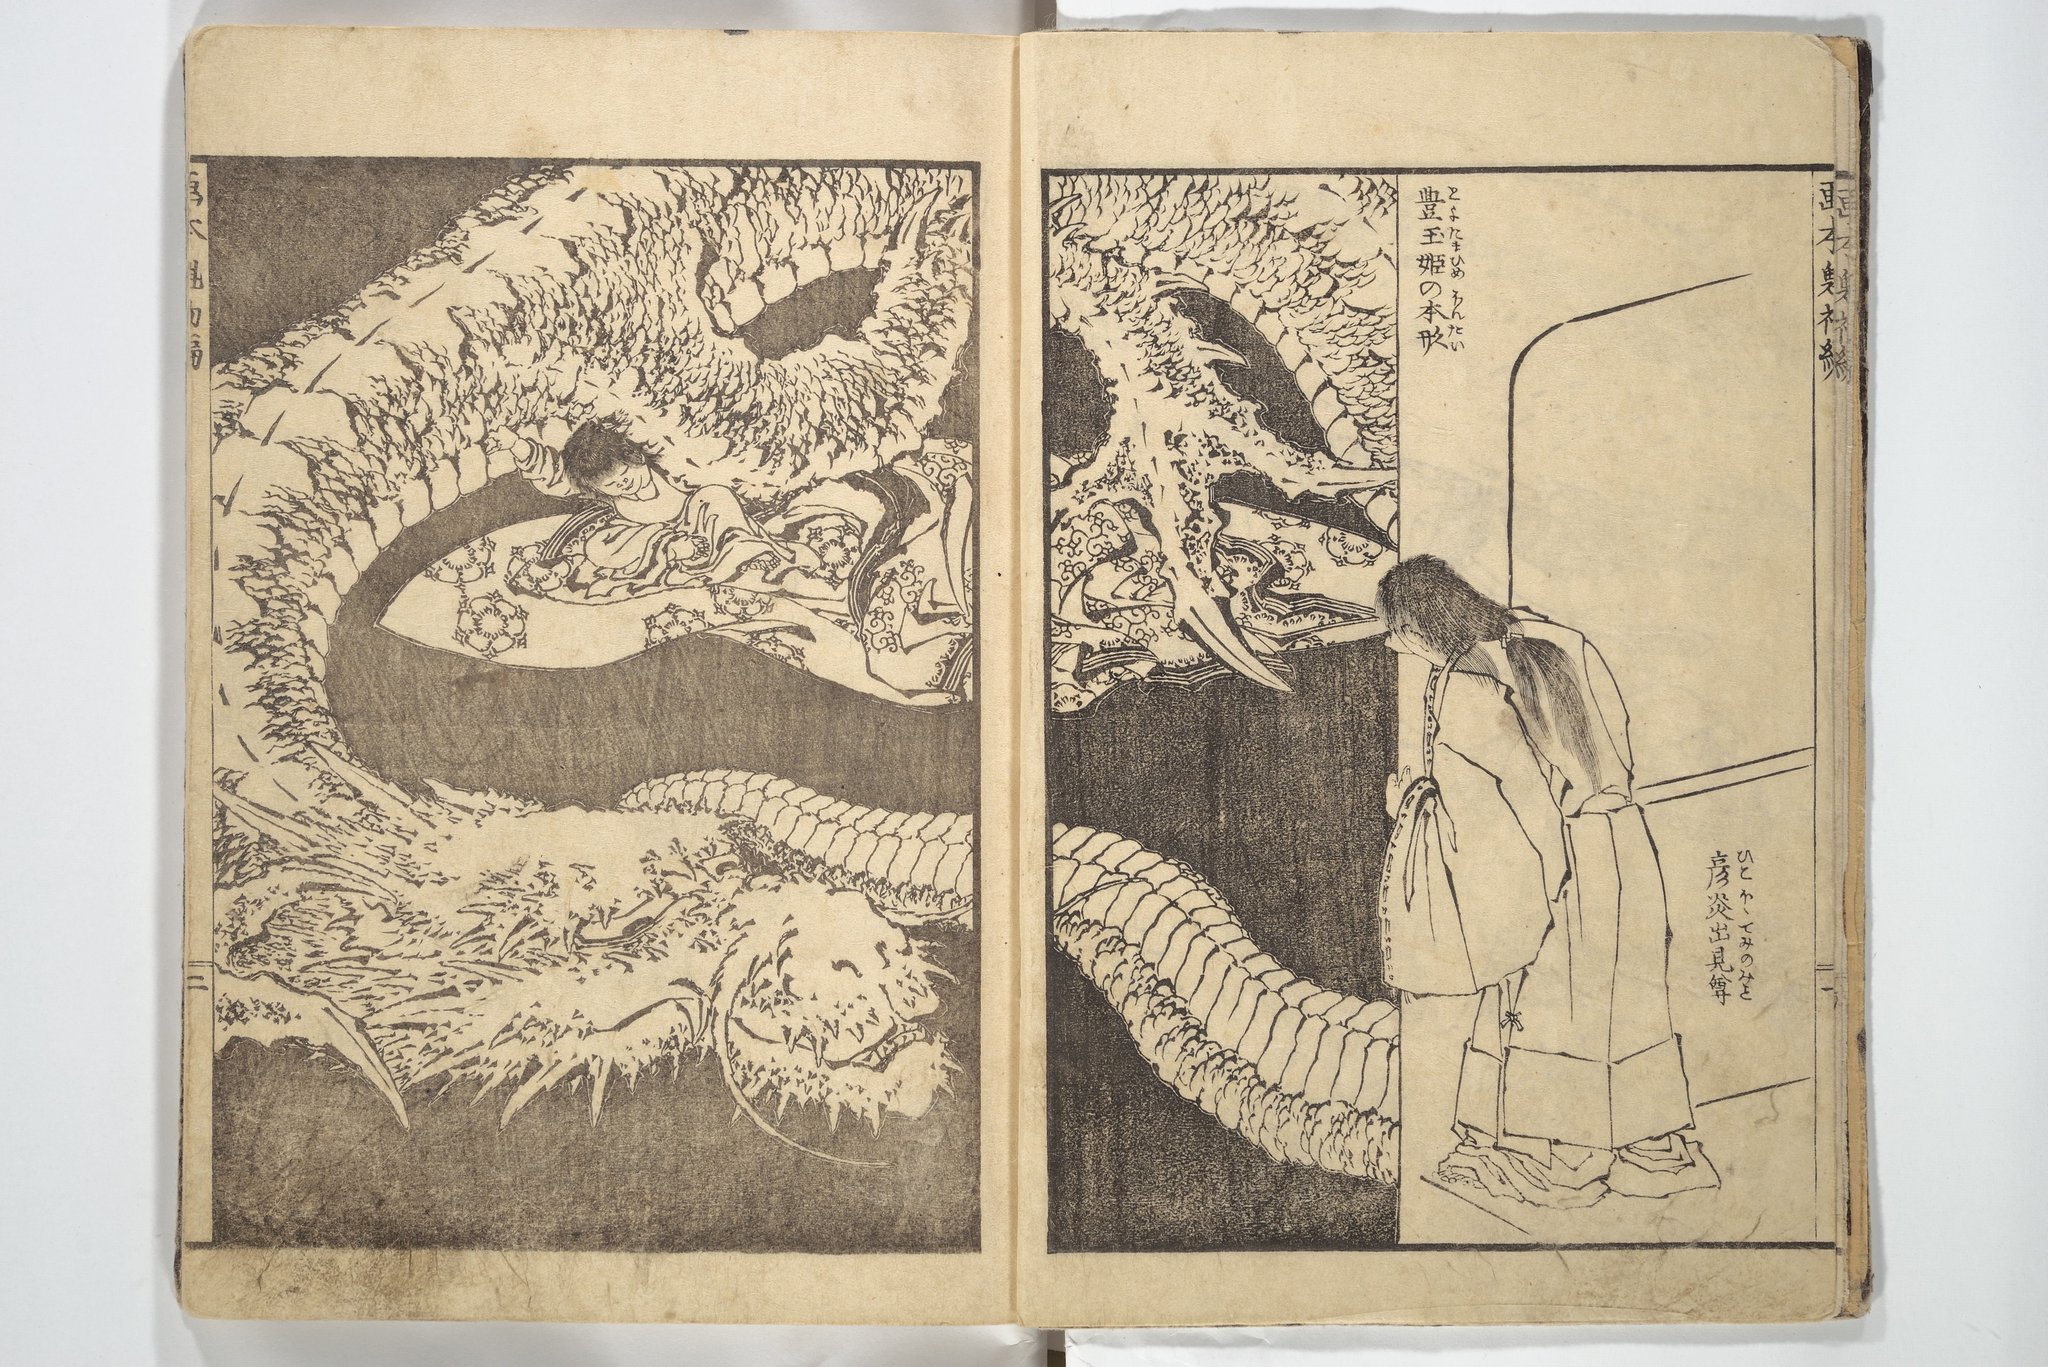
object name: illustrated book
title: Picture Book of Chinese and Japanese Warriors (Wakan ehon sakigake) 和漢 絵本魁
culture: japanese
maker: katsushika hokusai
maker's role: artist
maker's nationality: japanese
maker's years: 1760-1849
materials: ink, paper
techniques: woodblock print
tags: soldiers,dragons